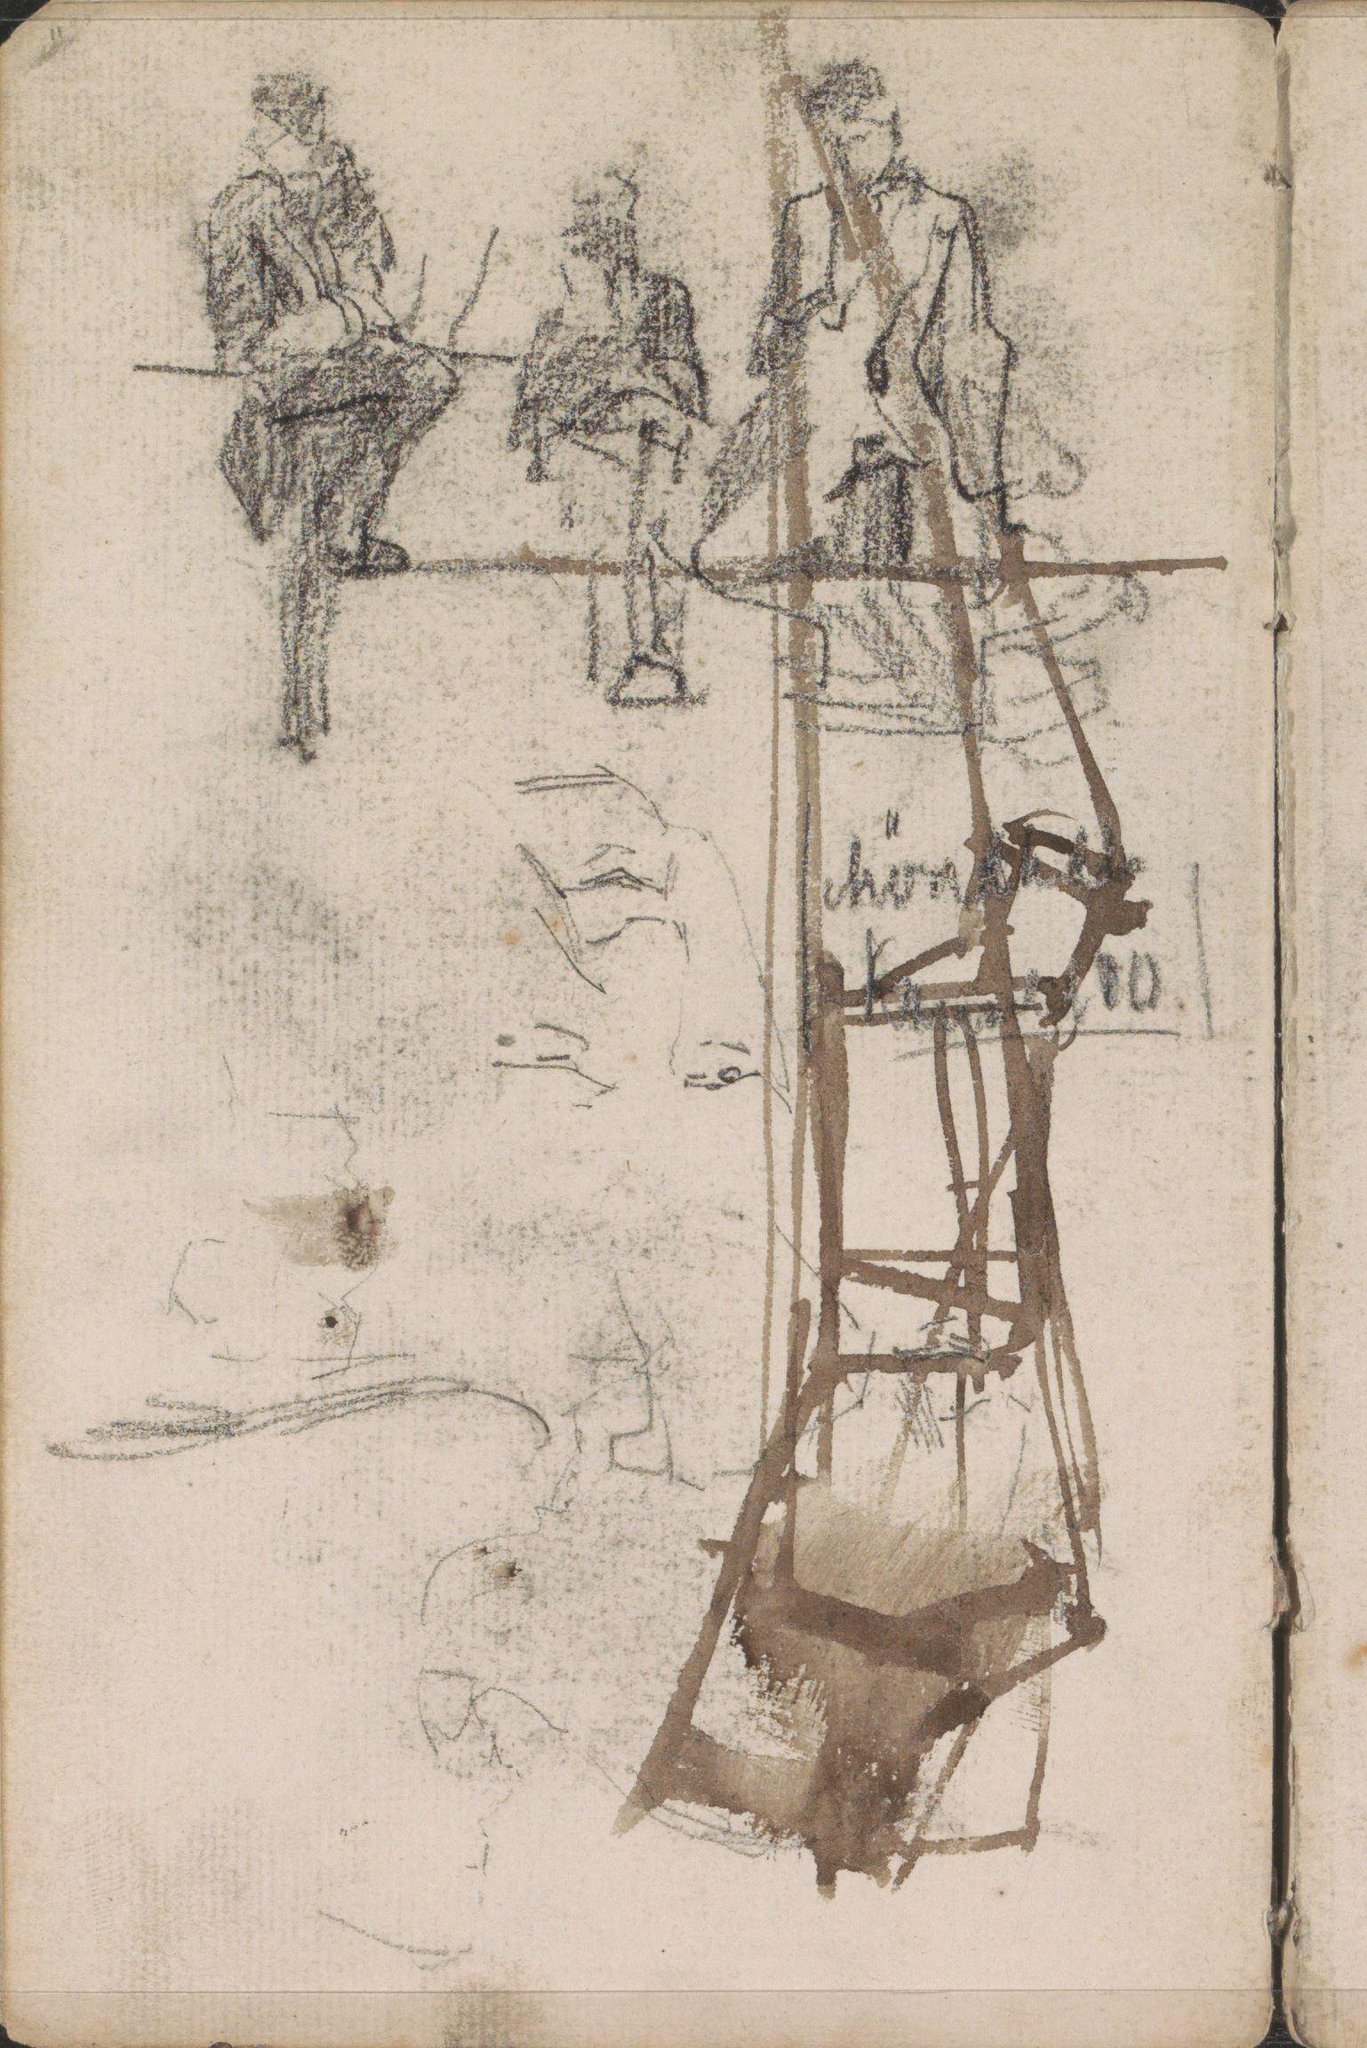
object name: sketchbook leaf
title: Studieblad, onder andere met figuren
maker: george hendrik breitner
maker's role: draughtsman, painter, print maker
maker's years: 1857-1923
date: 1880-1882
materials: chalk, paper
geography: the hague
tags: adult woman, adult man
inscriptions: annotation: ‘[...]’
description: Pagina 11 uit een schetsboek met 29 bladen.